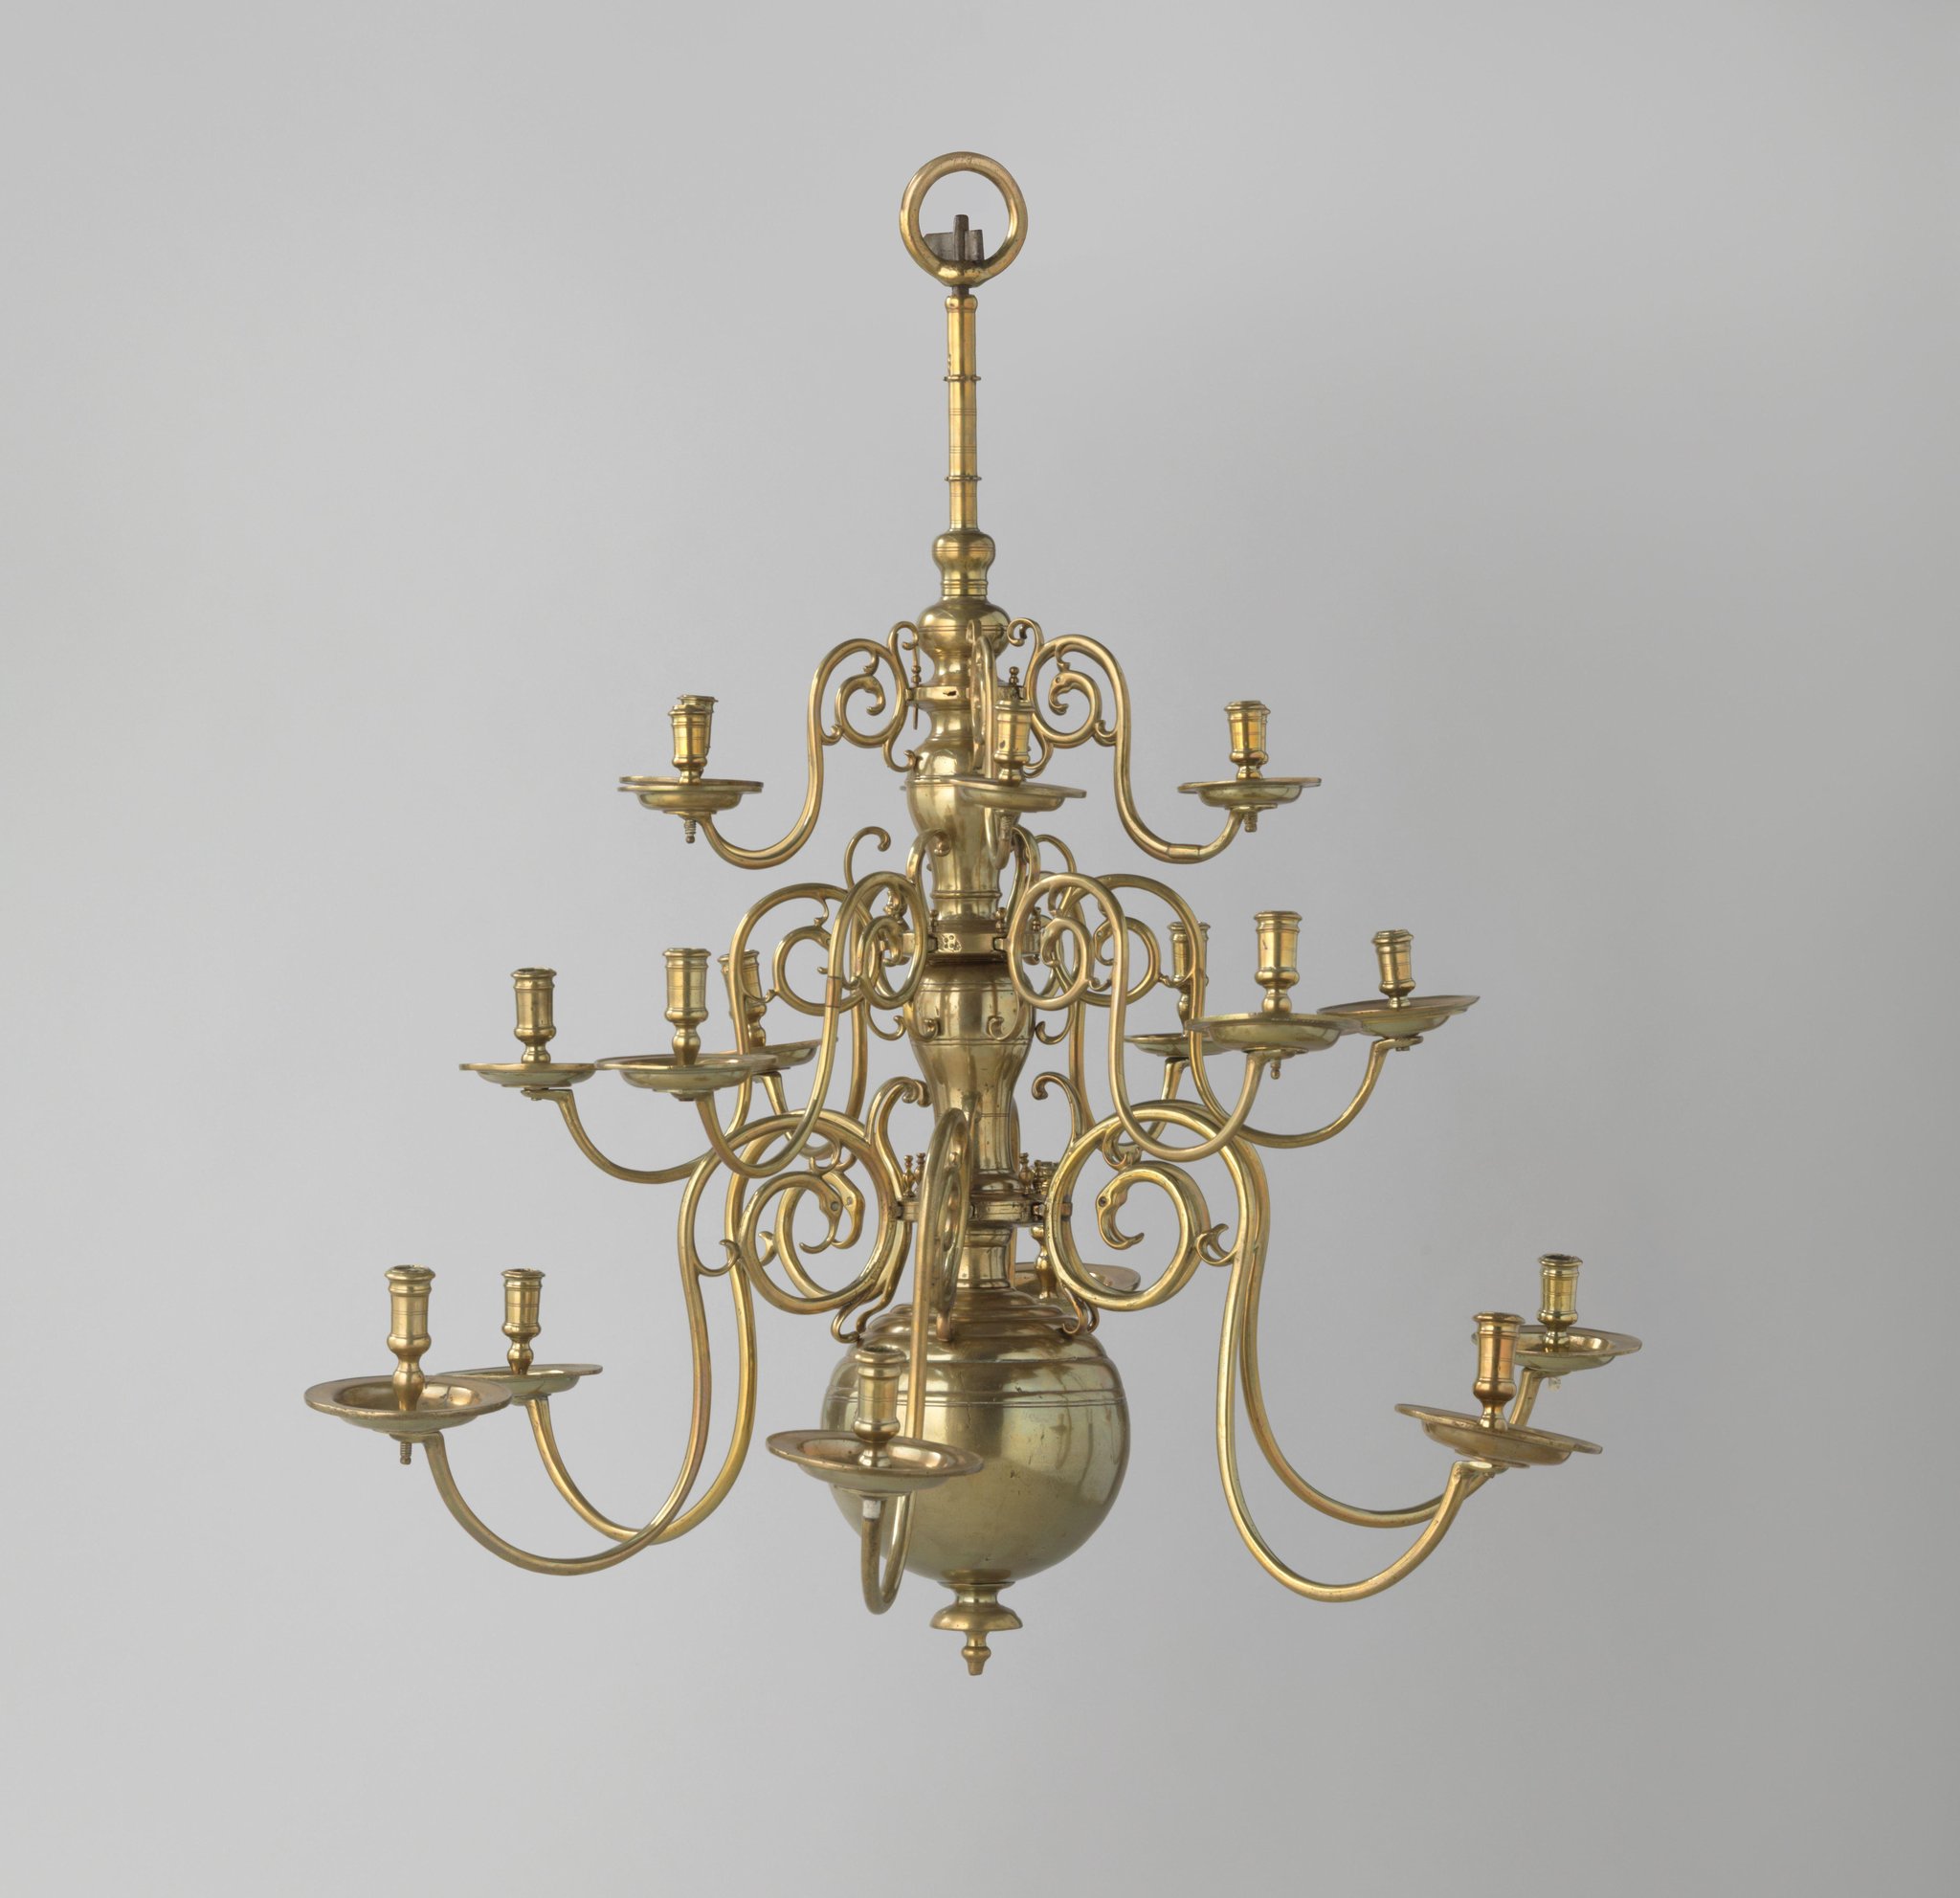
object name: chandelier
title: Arm met kaarsenhouder van kaarsenkroon van drie hoogten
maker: Anonymous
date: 1675-1725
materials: brass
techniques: casting, turning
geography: southern netherlands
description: Kaarsenarm behorende bij een messing kaarsenkroon van drie hoogten. De S-vormige arm heeft een krul en gaat naar buiten toe over in het platte verdikking met een schroefgat. Daarin is de kaarsenhouder met de vetvanger vastgezet. De vetvanger is aan de onderzijde geribd geprofileerd rond de opening en heeft verder twee maal twee gegroefde ringen. De cylindrische kaarsenhouder, die een geprofileerde uitstekende rand, twee gegroefde ringen en een verdikking onderaan heeft, gaat over in een baluster met onderaan het eind met schroefdraad en een knopje, waarin het centergat te zien is. Dit is de tweede arm van de bovenste standring, genummerd met 2 ronde punten. De pin, om de arm aan de standring te bevestigen, is spievormig.